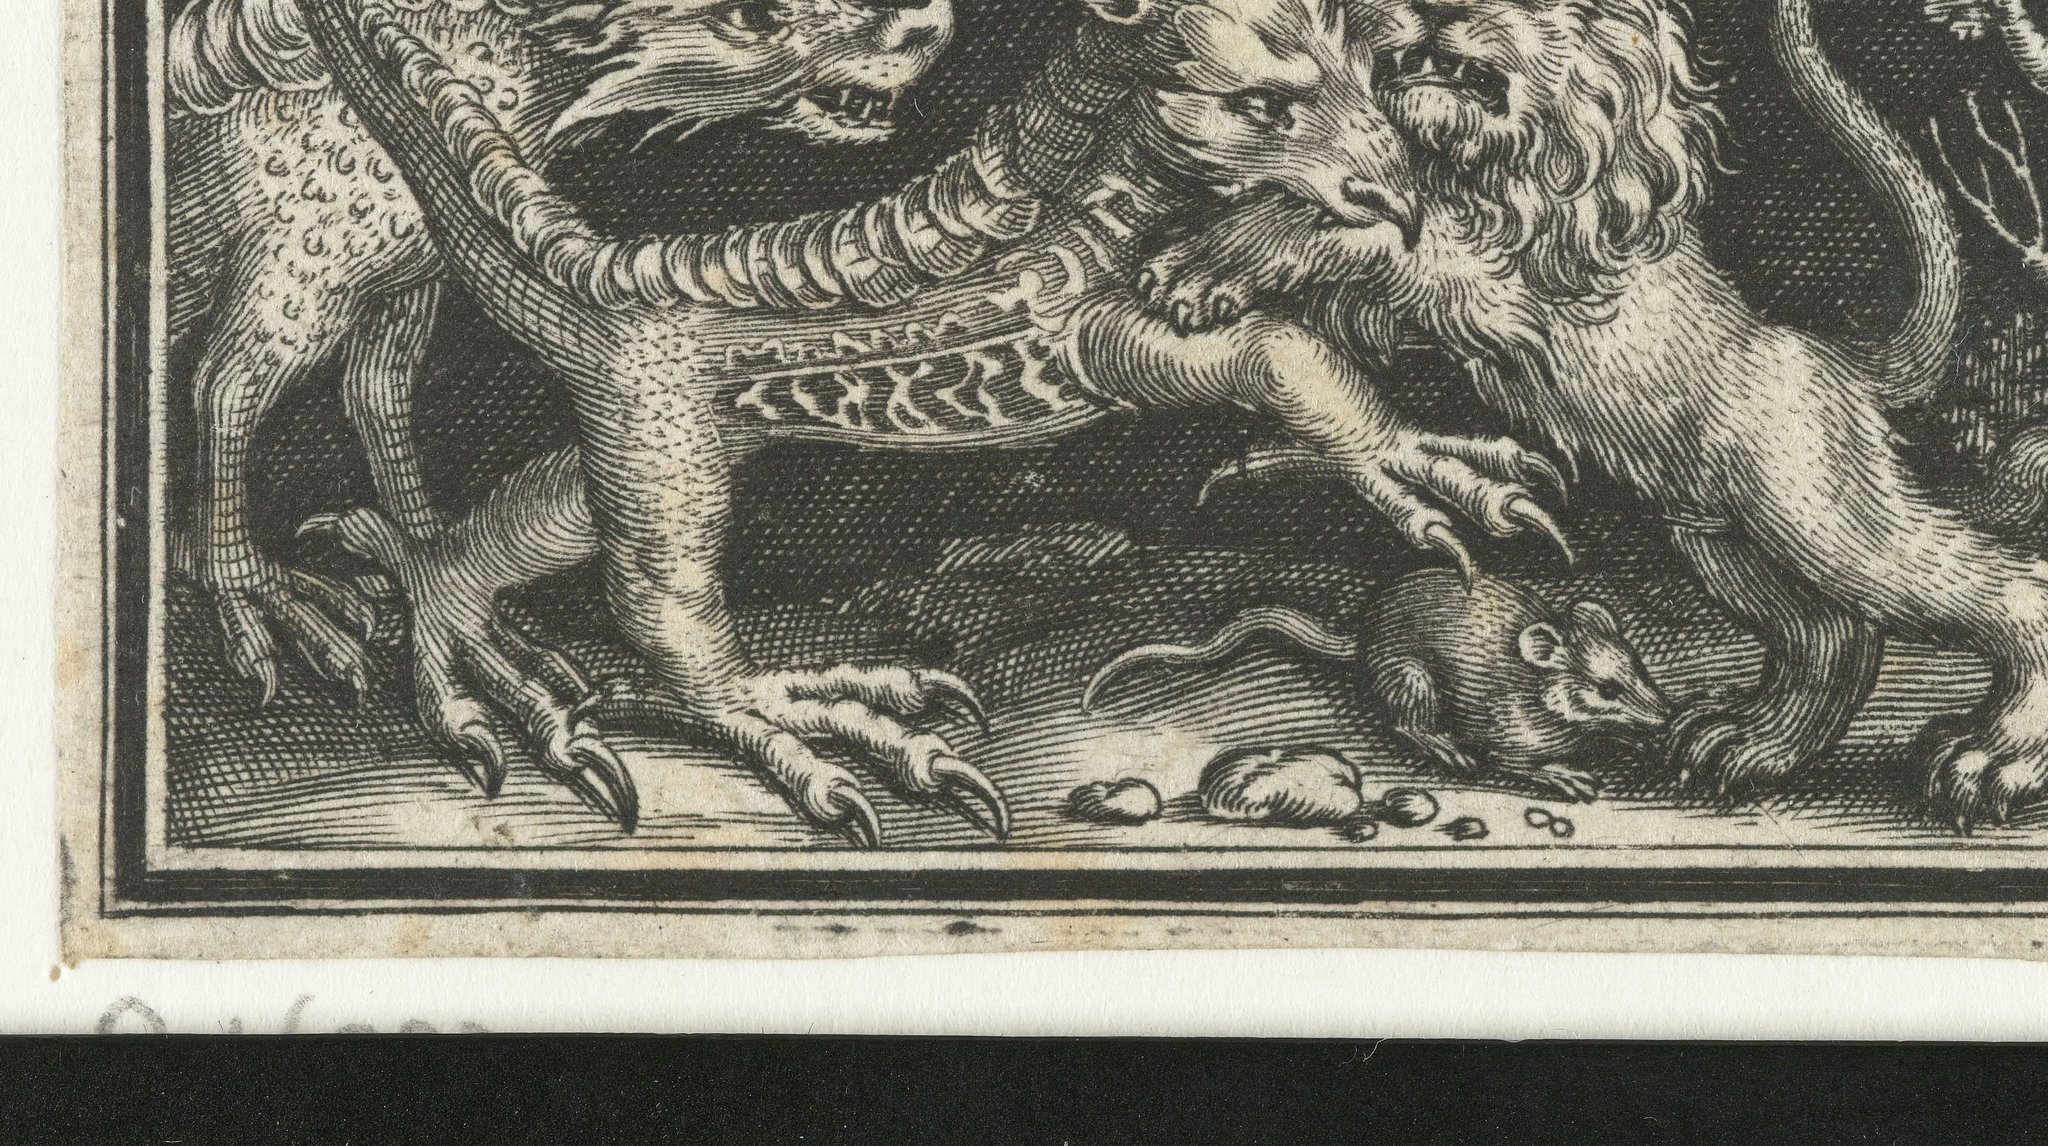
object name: print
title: Leeuw in gevecht met fantasiewezens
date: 1594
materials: paper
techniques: engraving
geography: netherlands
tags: beasts of prey, predatory animals: lion, fabulous animals (sometimes wrongly called 'grotesques'); 'mostri' (ripa) (+ fighting animals; aggressive relations)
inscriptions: collector's mark: Lugt 2228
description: R. de Rosey nr. 194. Prent uit serie van twaalf kleine prentjes met dieren uit fabels. Eenzelfde serie is ook uitgegeven door Visscher (Fuhring, 1989).